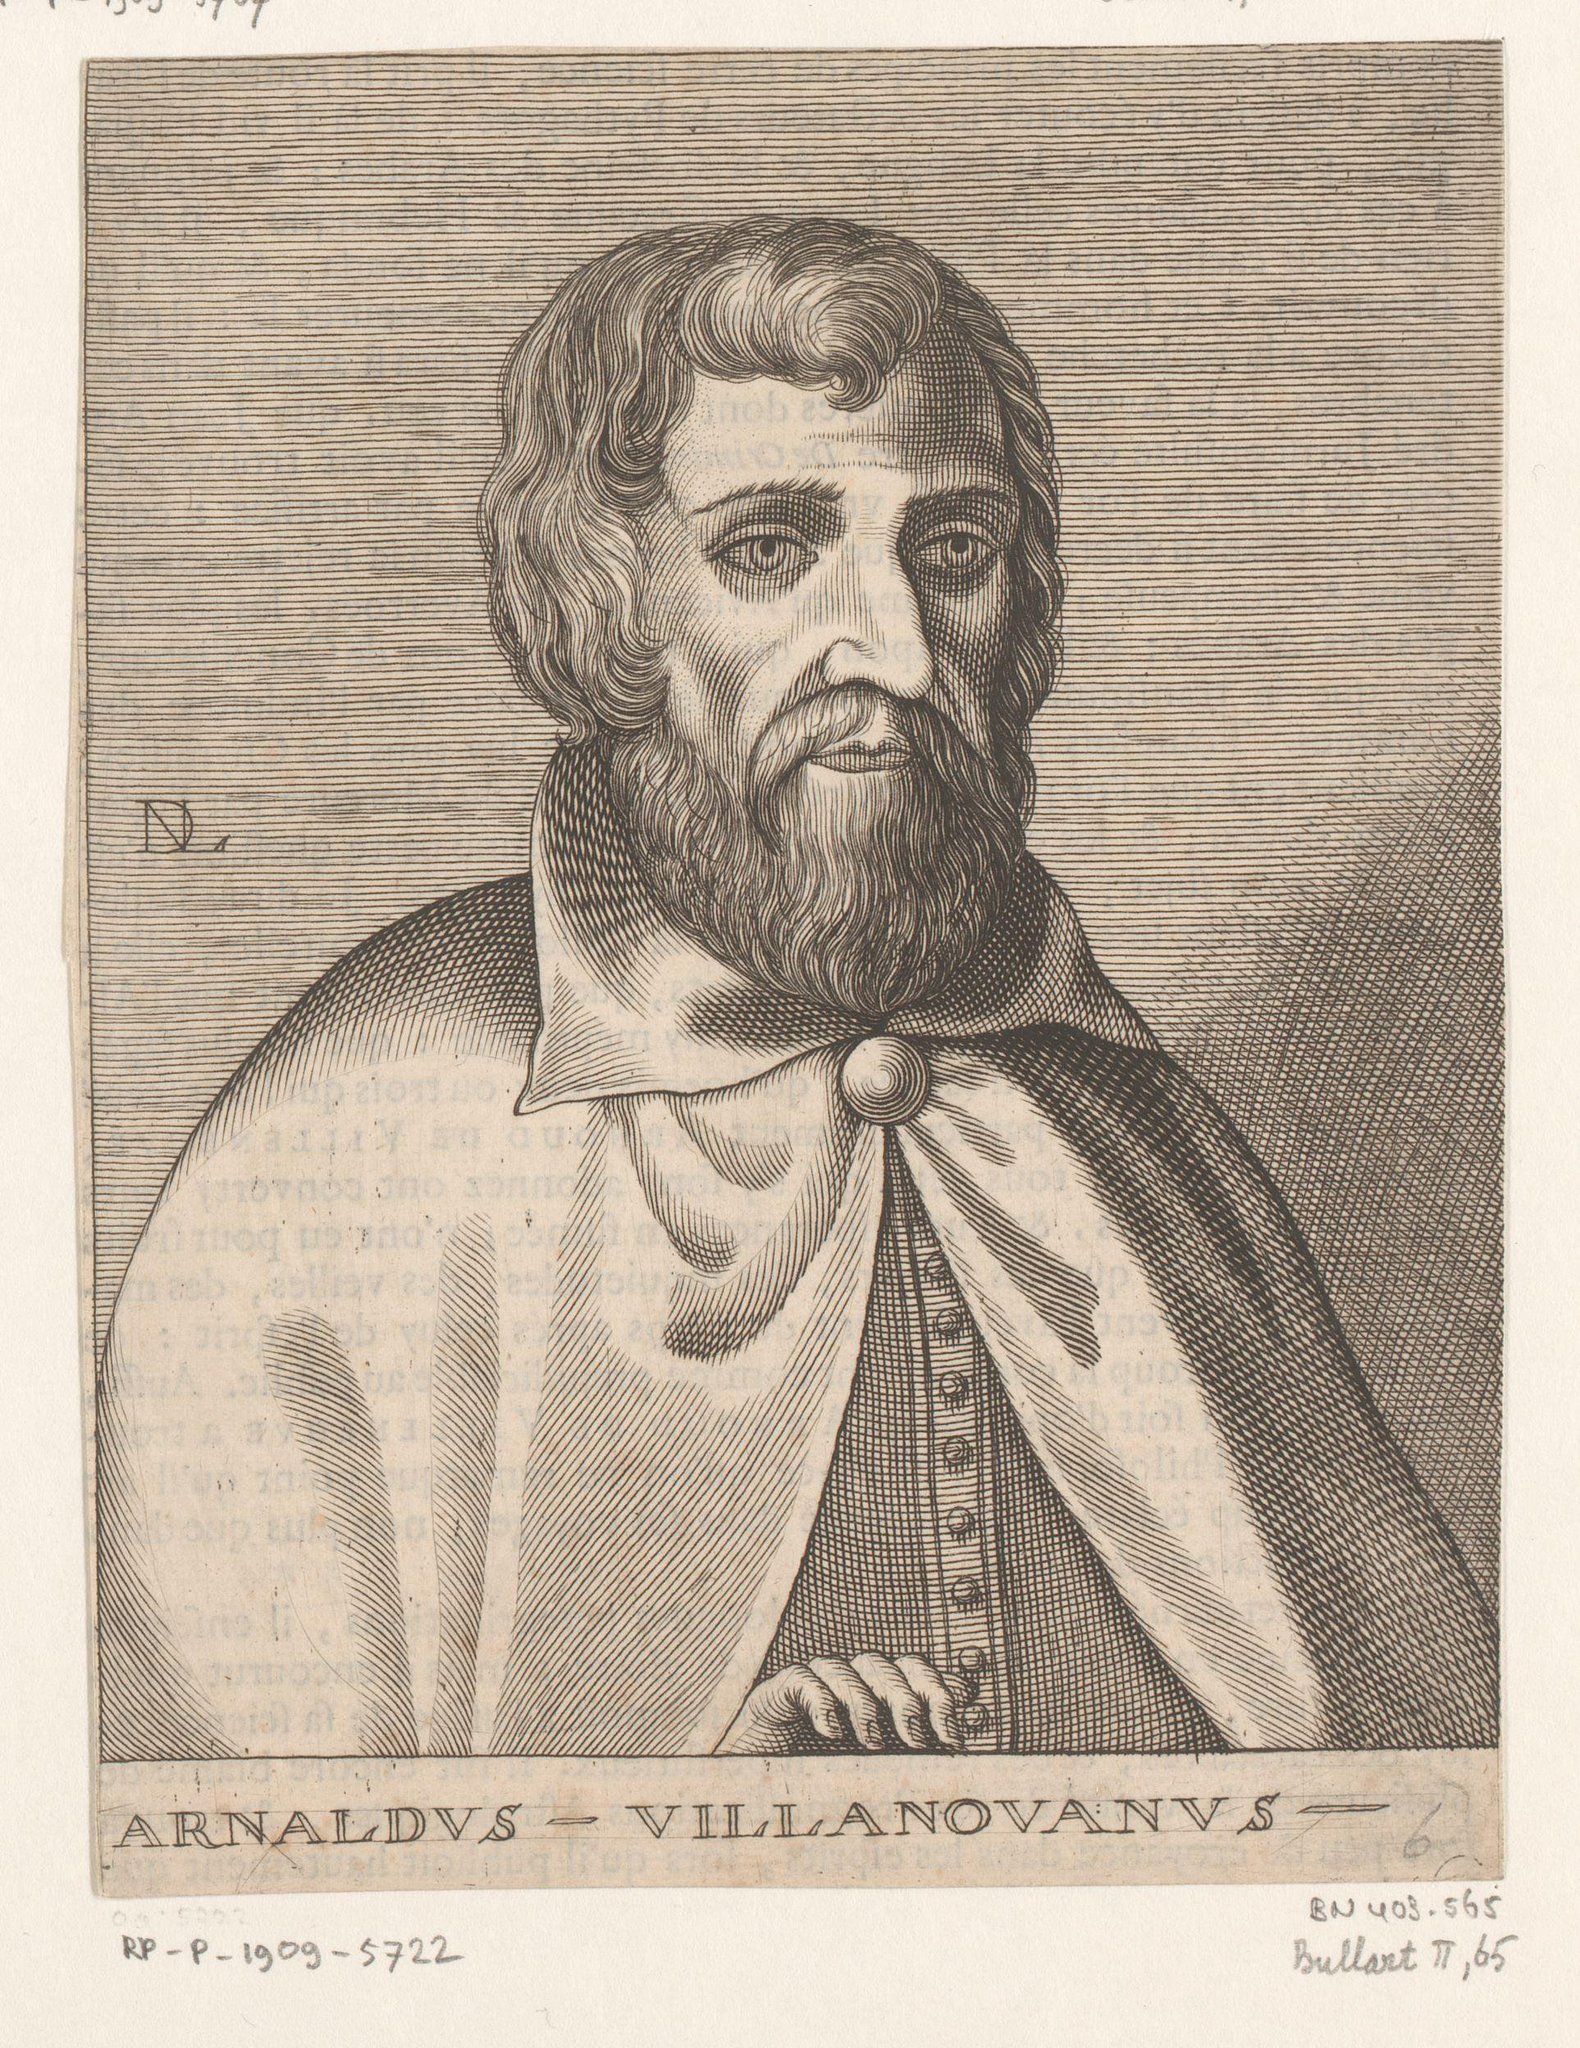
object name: print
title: Arnaldus Villanovanus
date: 1682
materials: paper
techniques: engraving, letterpress printing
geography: brussels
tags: historical persons, physician, doctor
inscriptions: collector's mark: Lugt 2228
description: Prent gebruikt voor: Bullart, Isaac. Académie des Sciences et Arts contenant les vies et éloges his. des hommes illustres qui ont excellé en ces professions depuis environ quatre siècles. Brussel: François Foppens, 1682. Het boek werd in 1682 eveneens in Amsterdam uitgegeven door de erfgenamen van Daniel Elzevier. Ieder portret betreft een illustratie bij de biografie van een kunstenaar of geleerde. De meeste portretten werden door Nicolas de Larmessin vervaardigd (162), 93 door De Boulonois en een derde door ongeïdentificeerde prentmakers. Dit betreft een illustratie op p. 65, deel II.